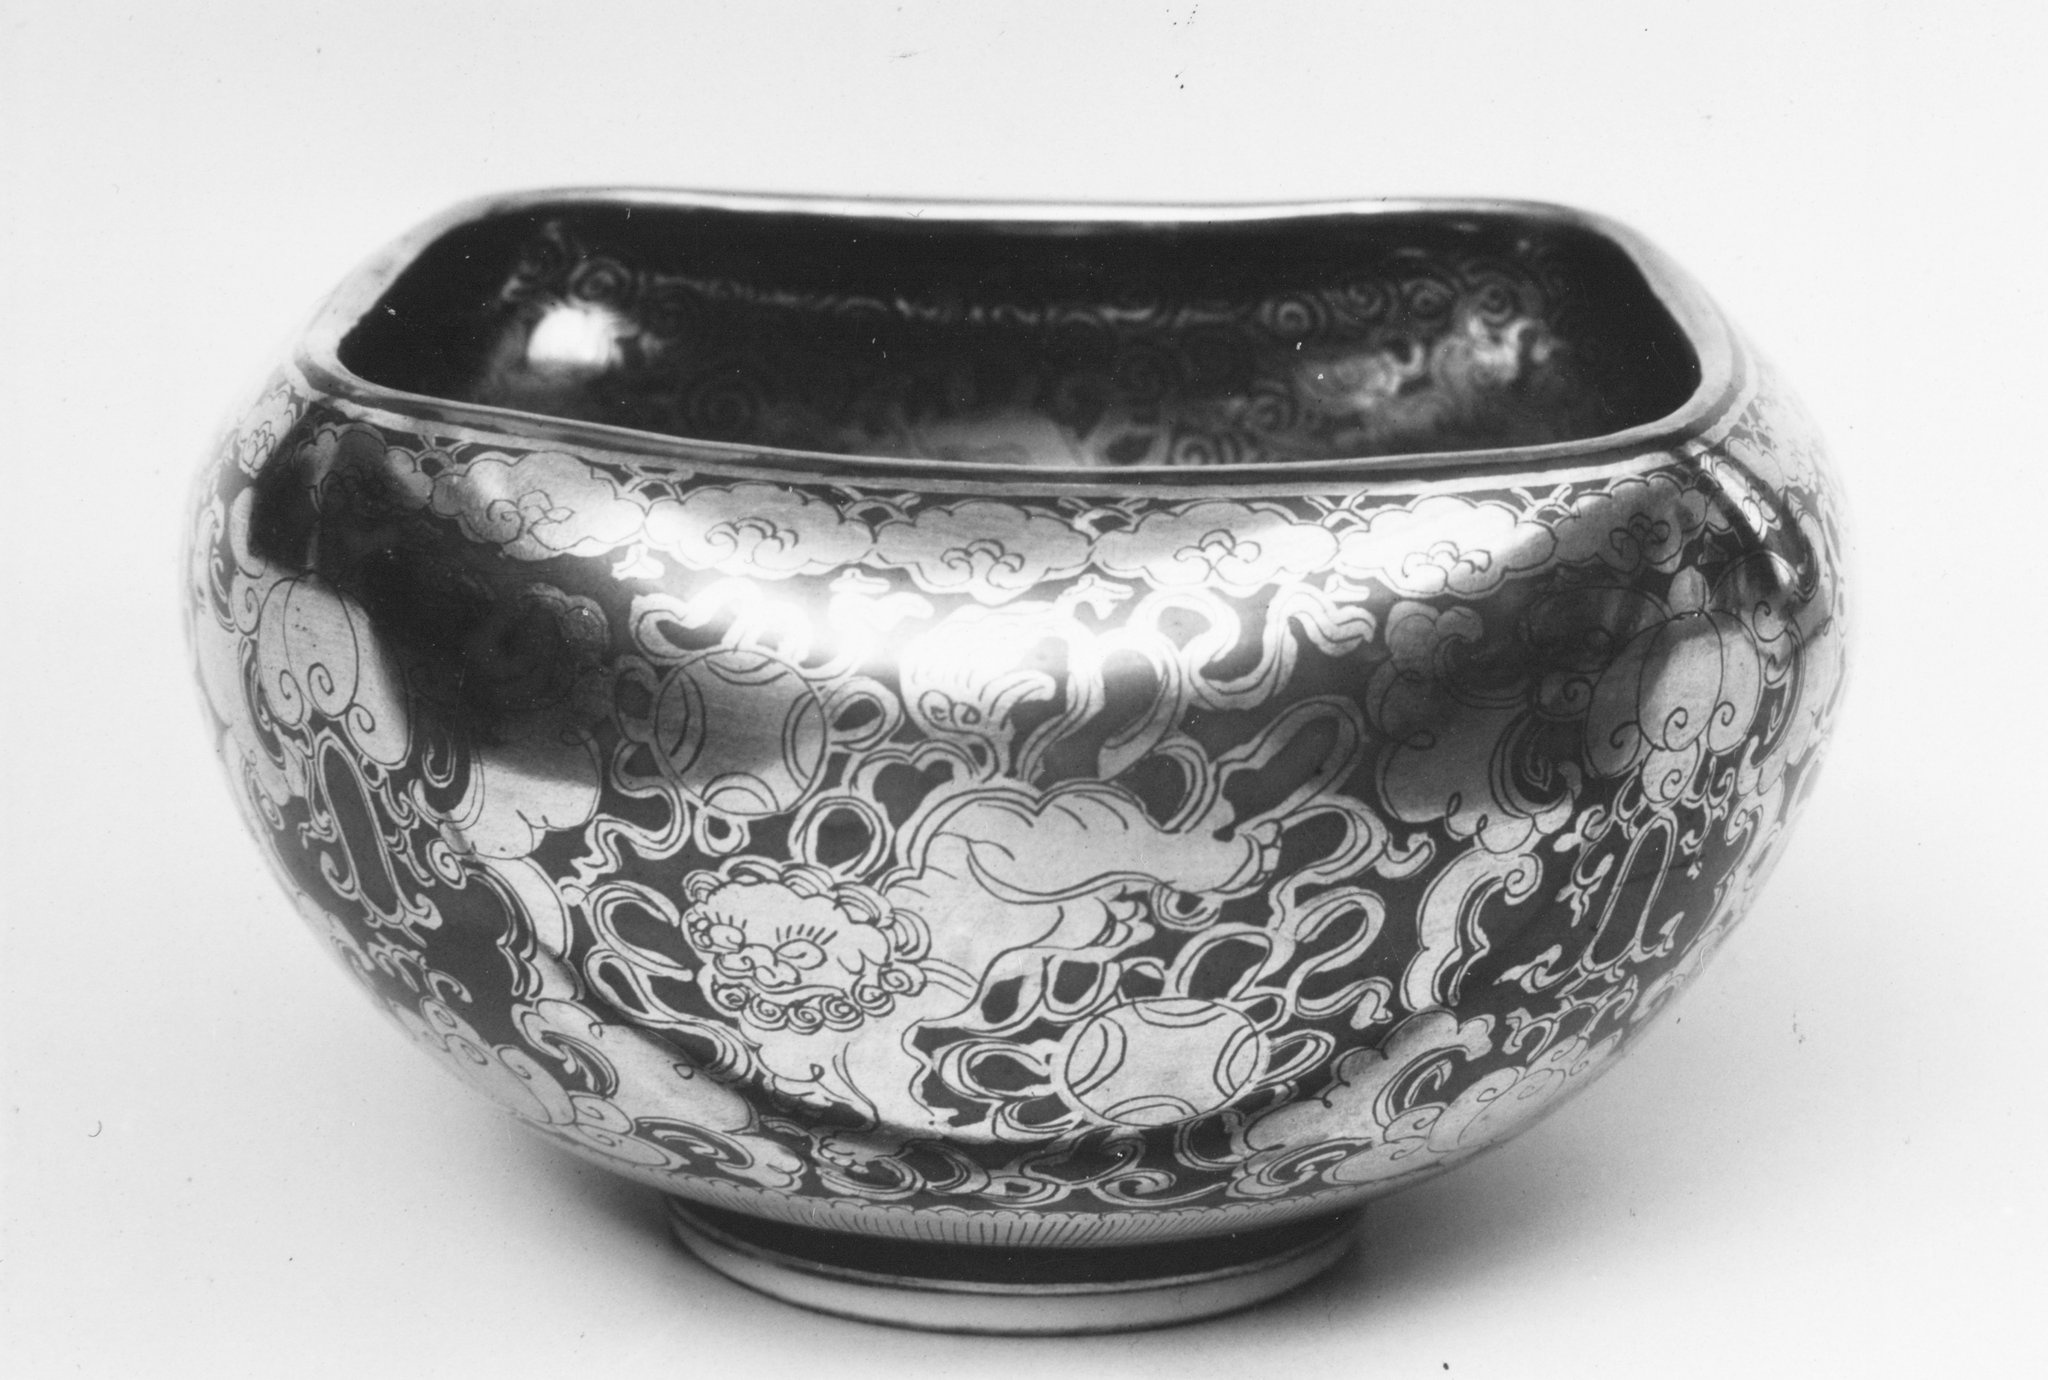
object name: bowl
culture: japanese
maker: eiraku hozen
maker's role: artist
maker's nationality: japanese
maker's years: 1795-1854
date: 1800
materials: enamel, gold, porcelain